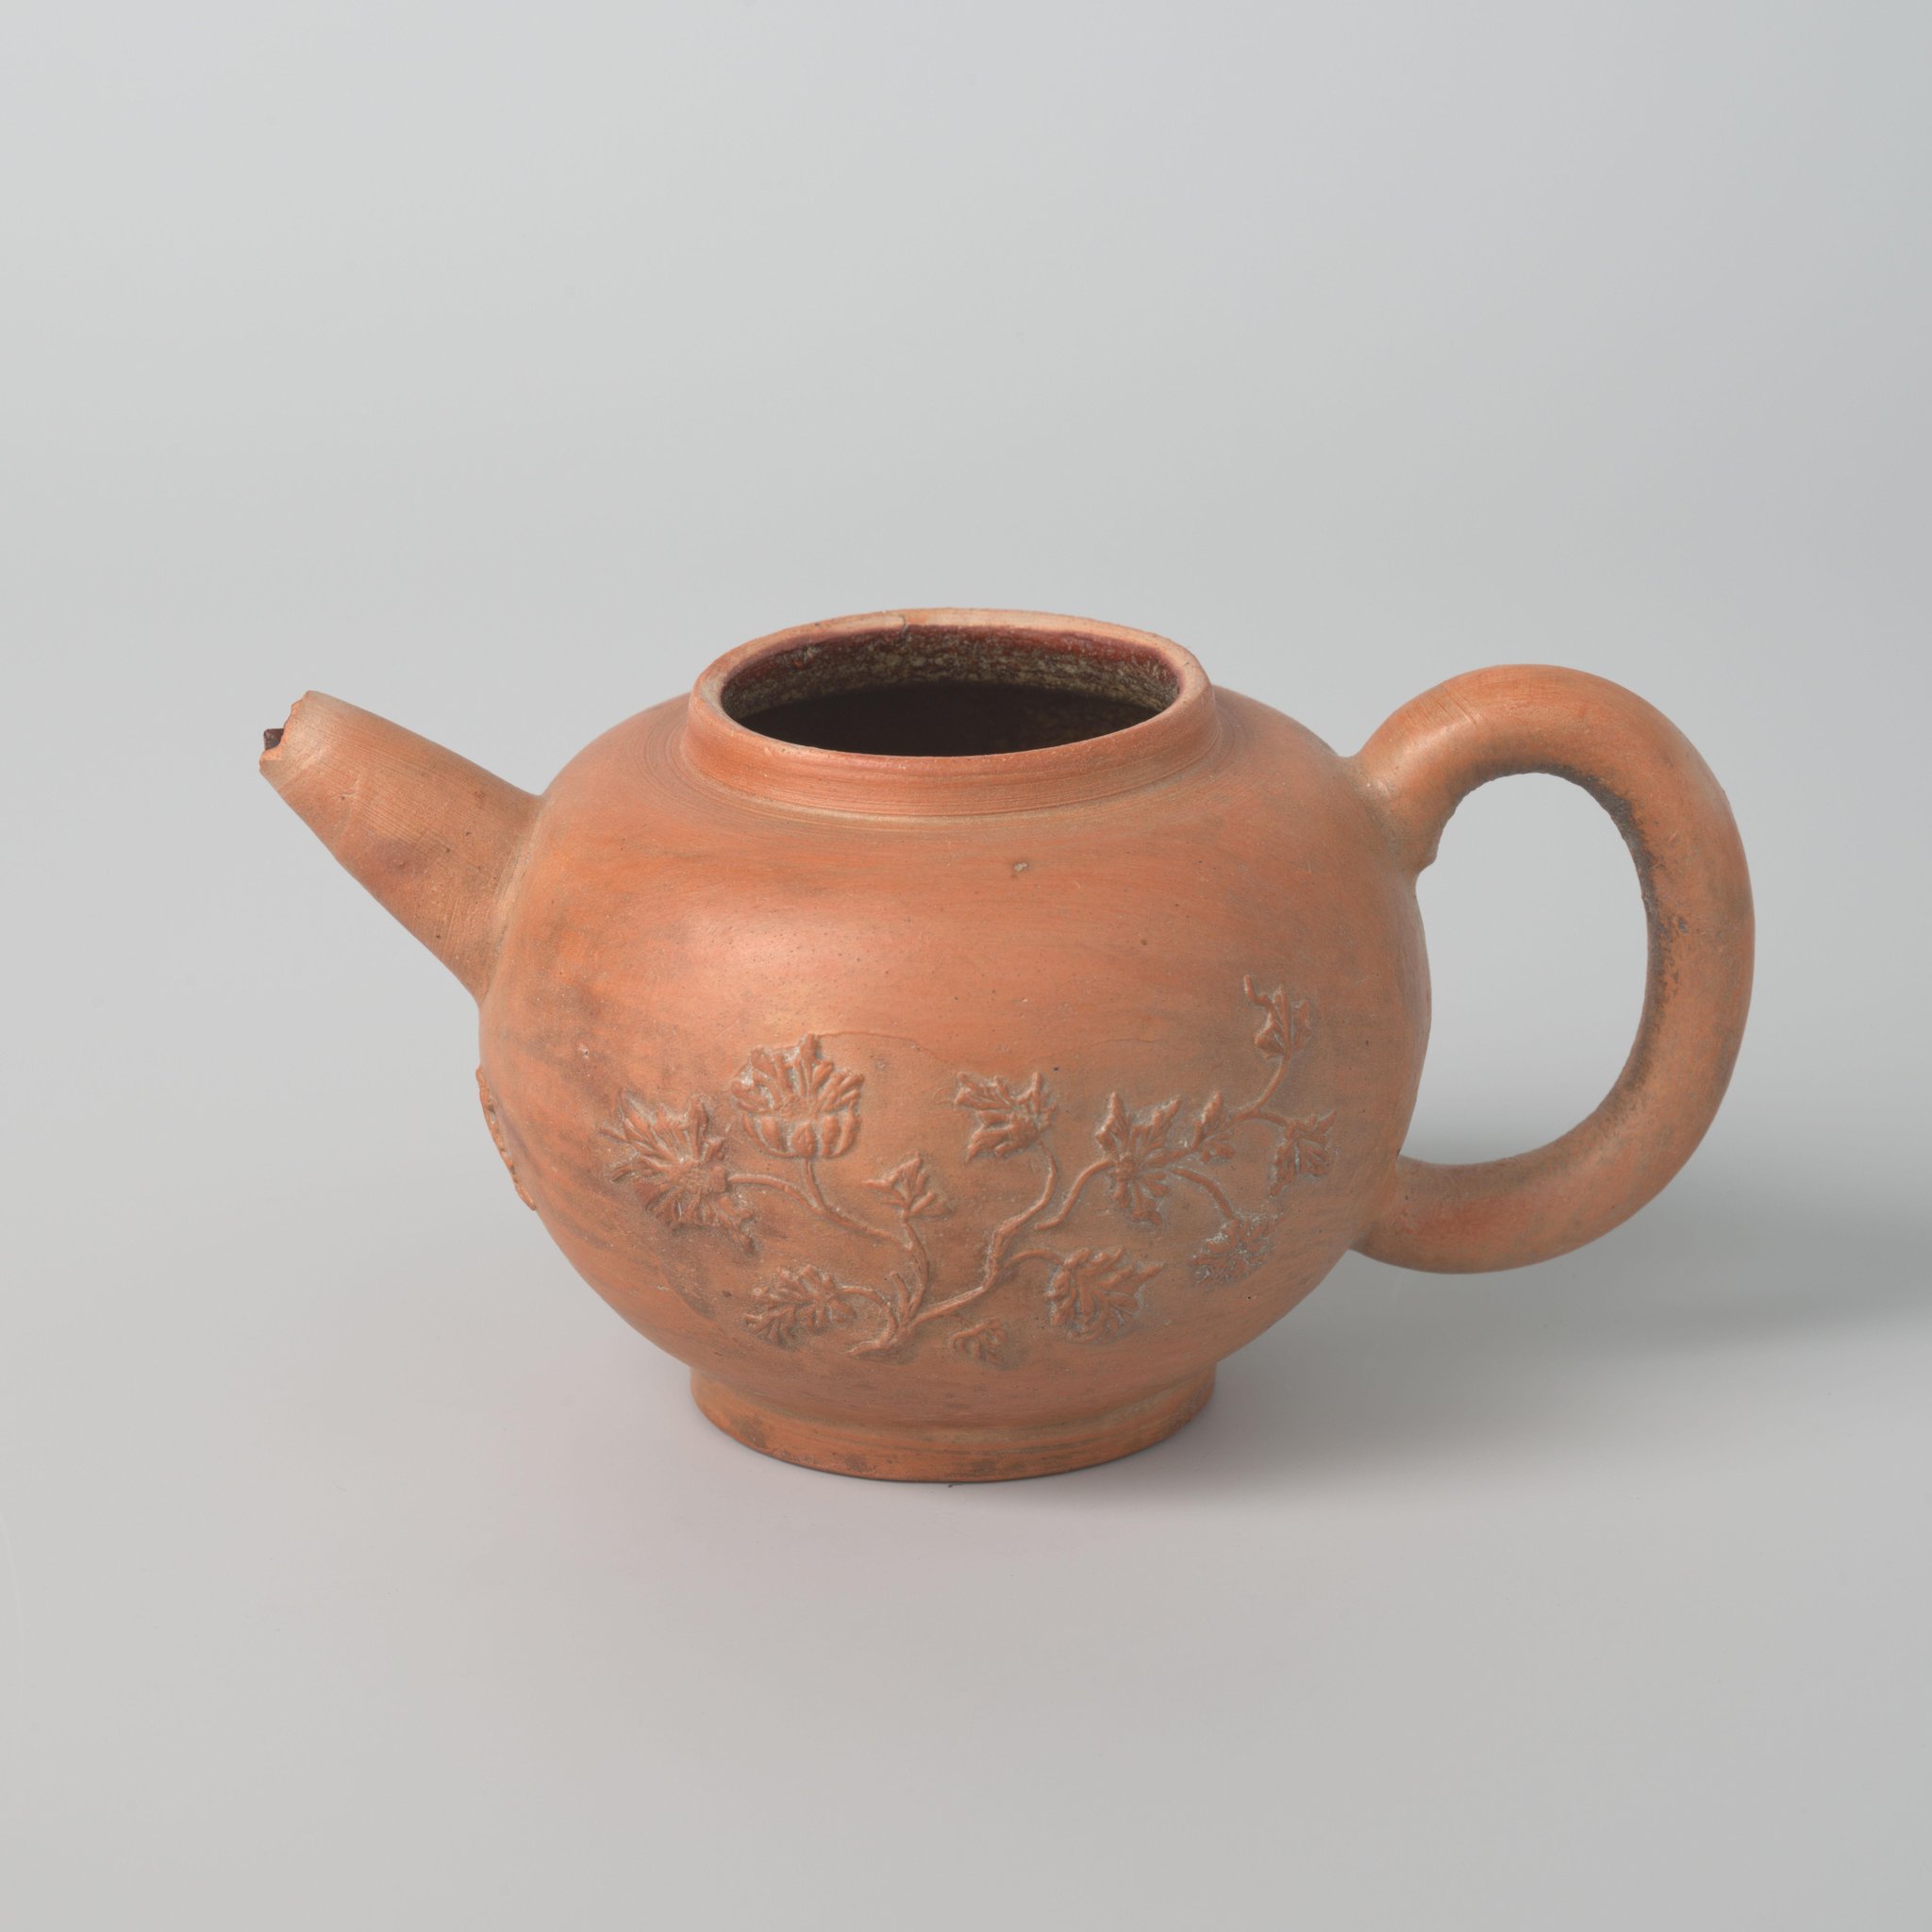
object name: teapot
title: Theepot met bloemtakken in reliëf (De Caluwe bakafval)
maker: jacobus de caluwe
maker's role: plateelbakkerij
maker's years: -1730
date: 1700-1725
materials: earthenware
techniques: firing, vitrification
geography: delft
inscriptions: mark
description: Toegeschreven aan Jacobus de Caluwe, omdat dit voorwerp samen met gemerkte stukken (‘Jacobus De Caluwe’ en rennend hert) gevonden is op de plaats waar zich De Caluwes tweede werkplaats bevond. Er is een duidelijke stilistische overeenkomst tussen de gemerkte en niet gemerkte voorwerpen uit deze archeologische vondst.